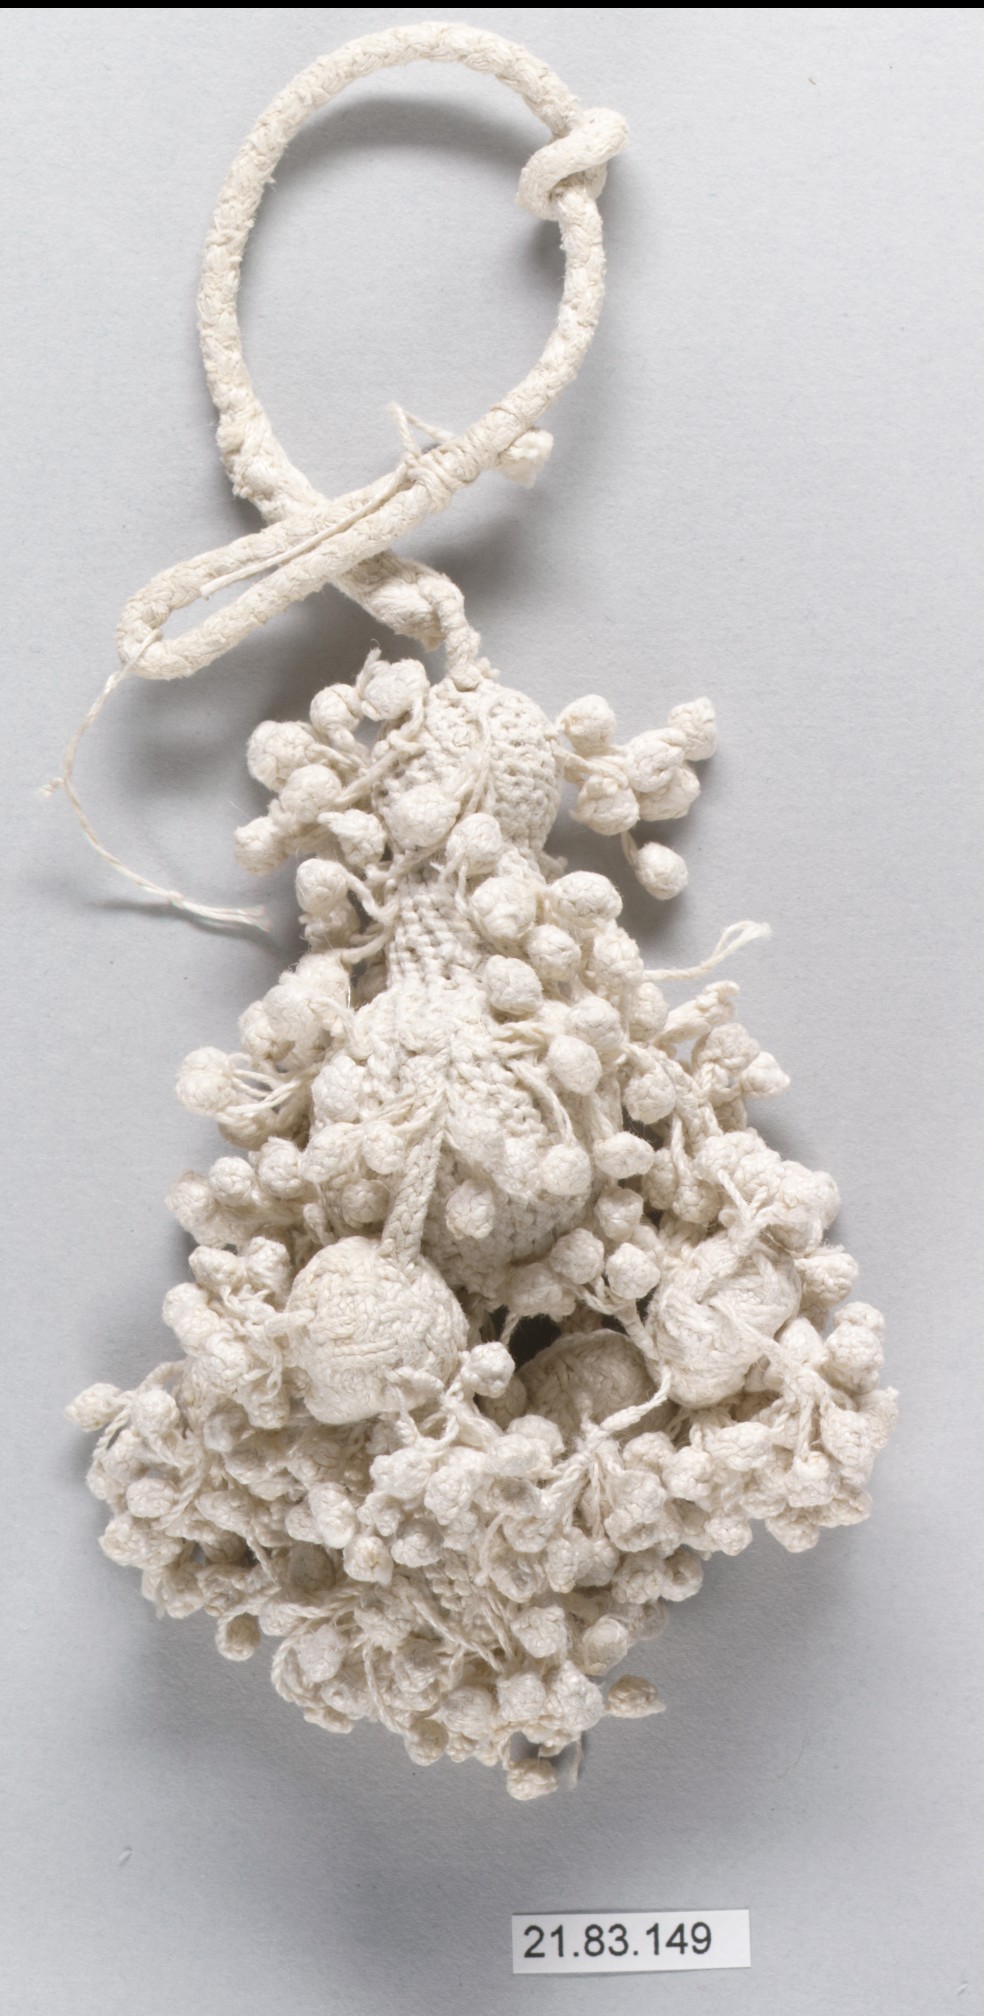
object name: tassel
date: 1601-1700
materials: linen